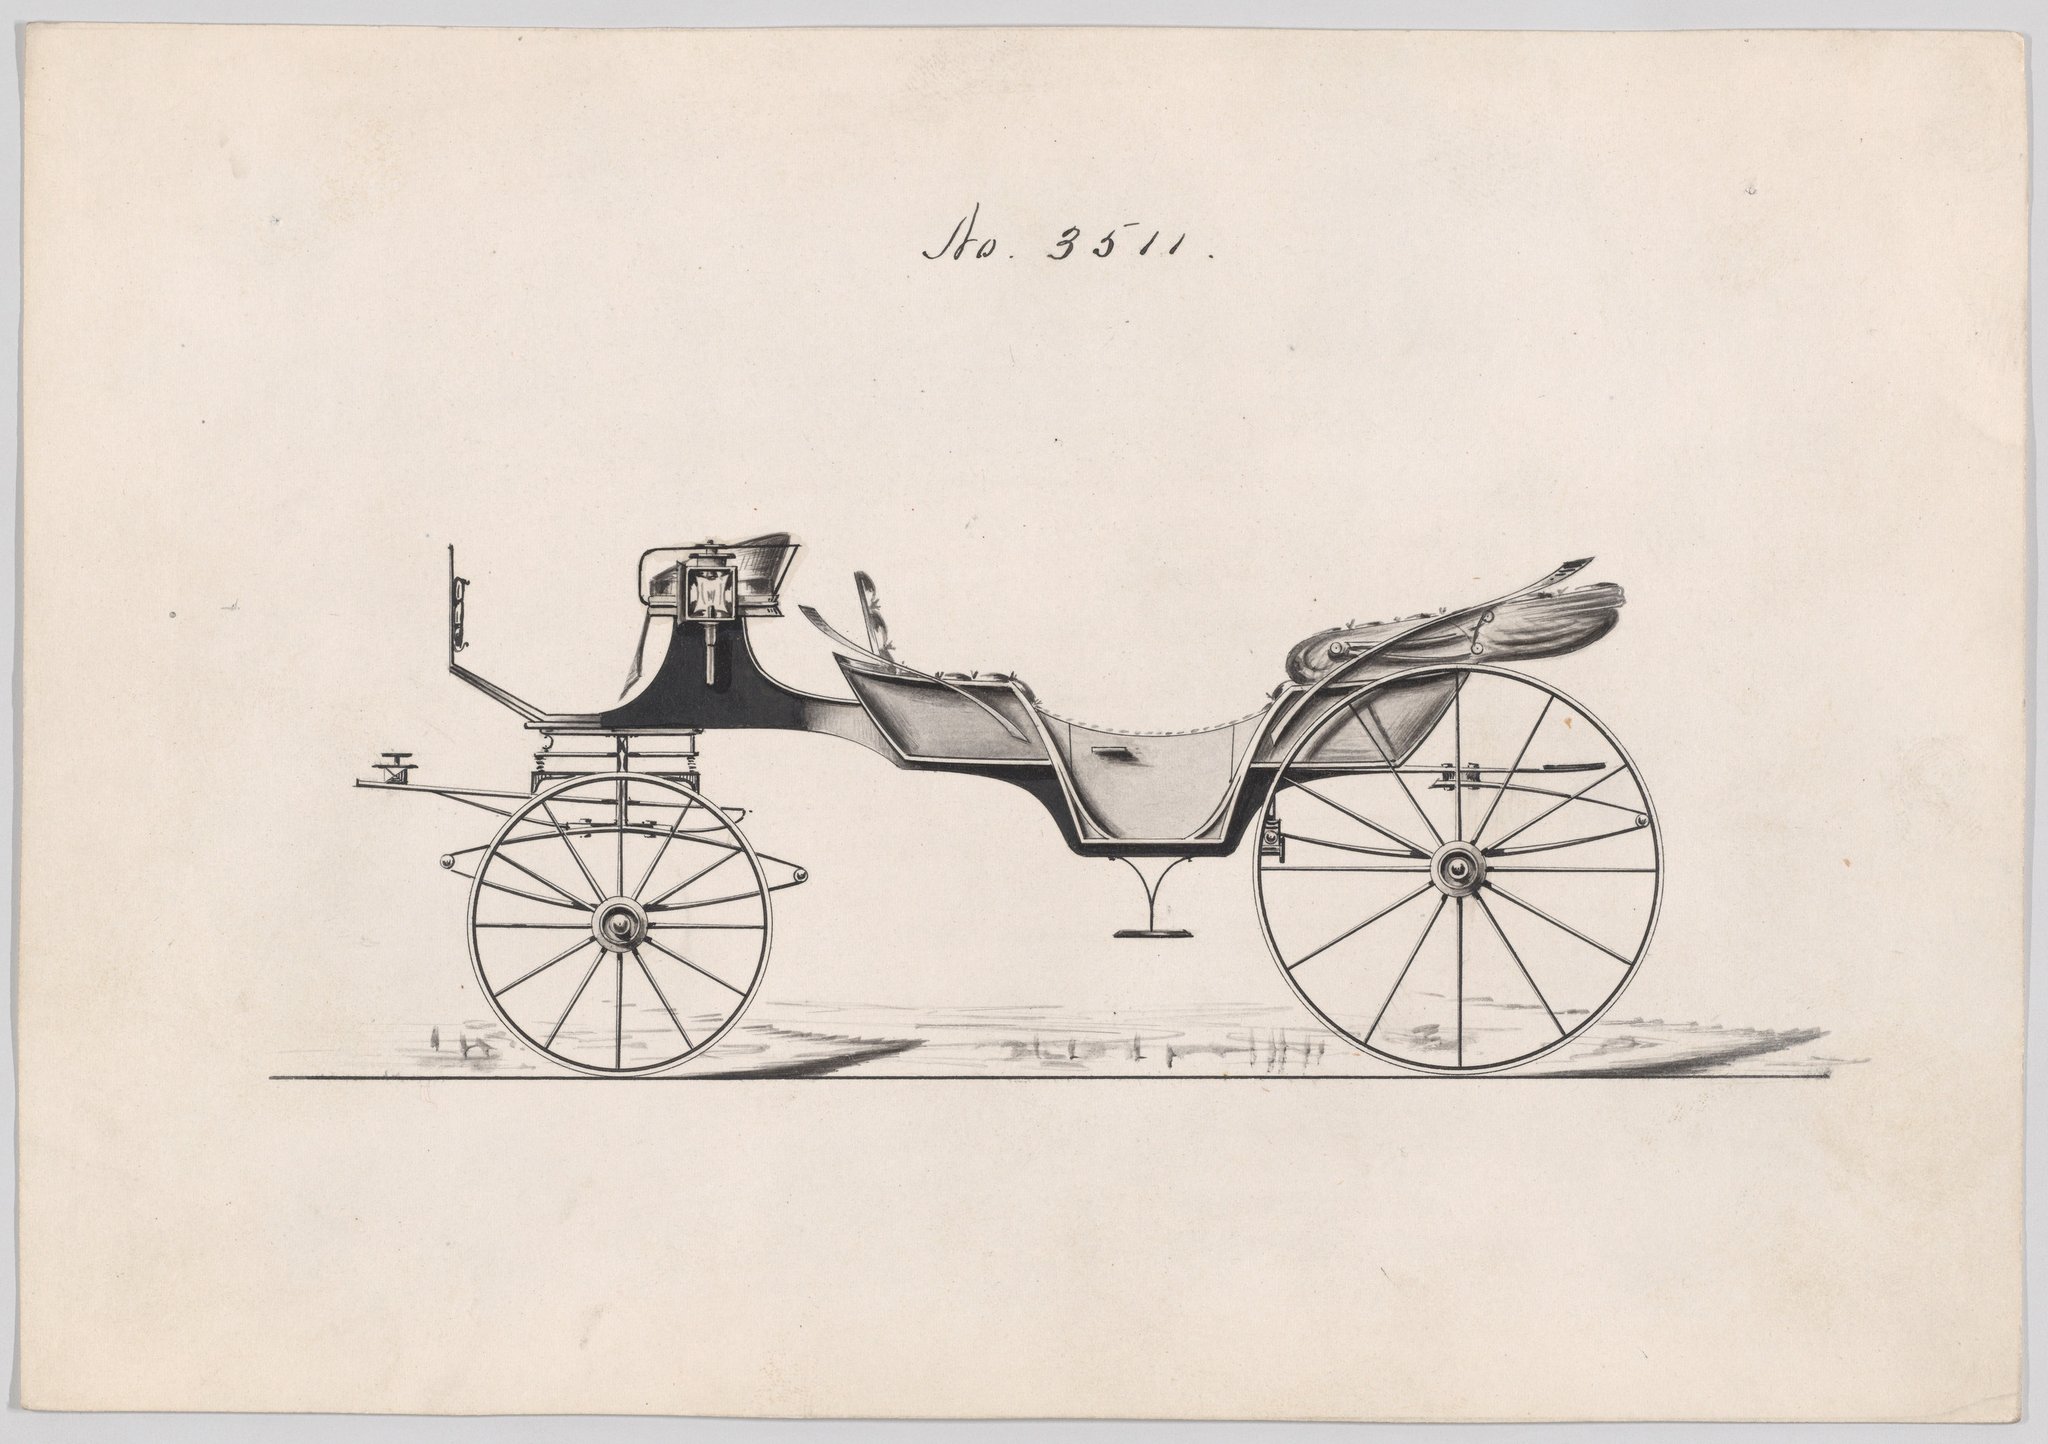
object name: drawing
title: Vis-à-vis #3511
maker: brewster & co.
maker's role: manufacturer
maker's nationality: american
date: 1879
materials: gouache, gum arabic, ink, watercolor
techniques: pen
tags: carriages